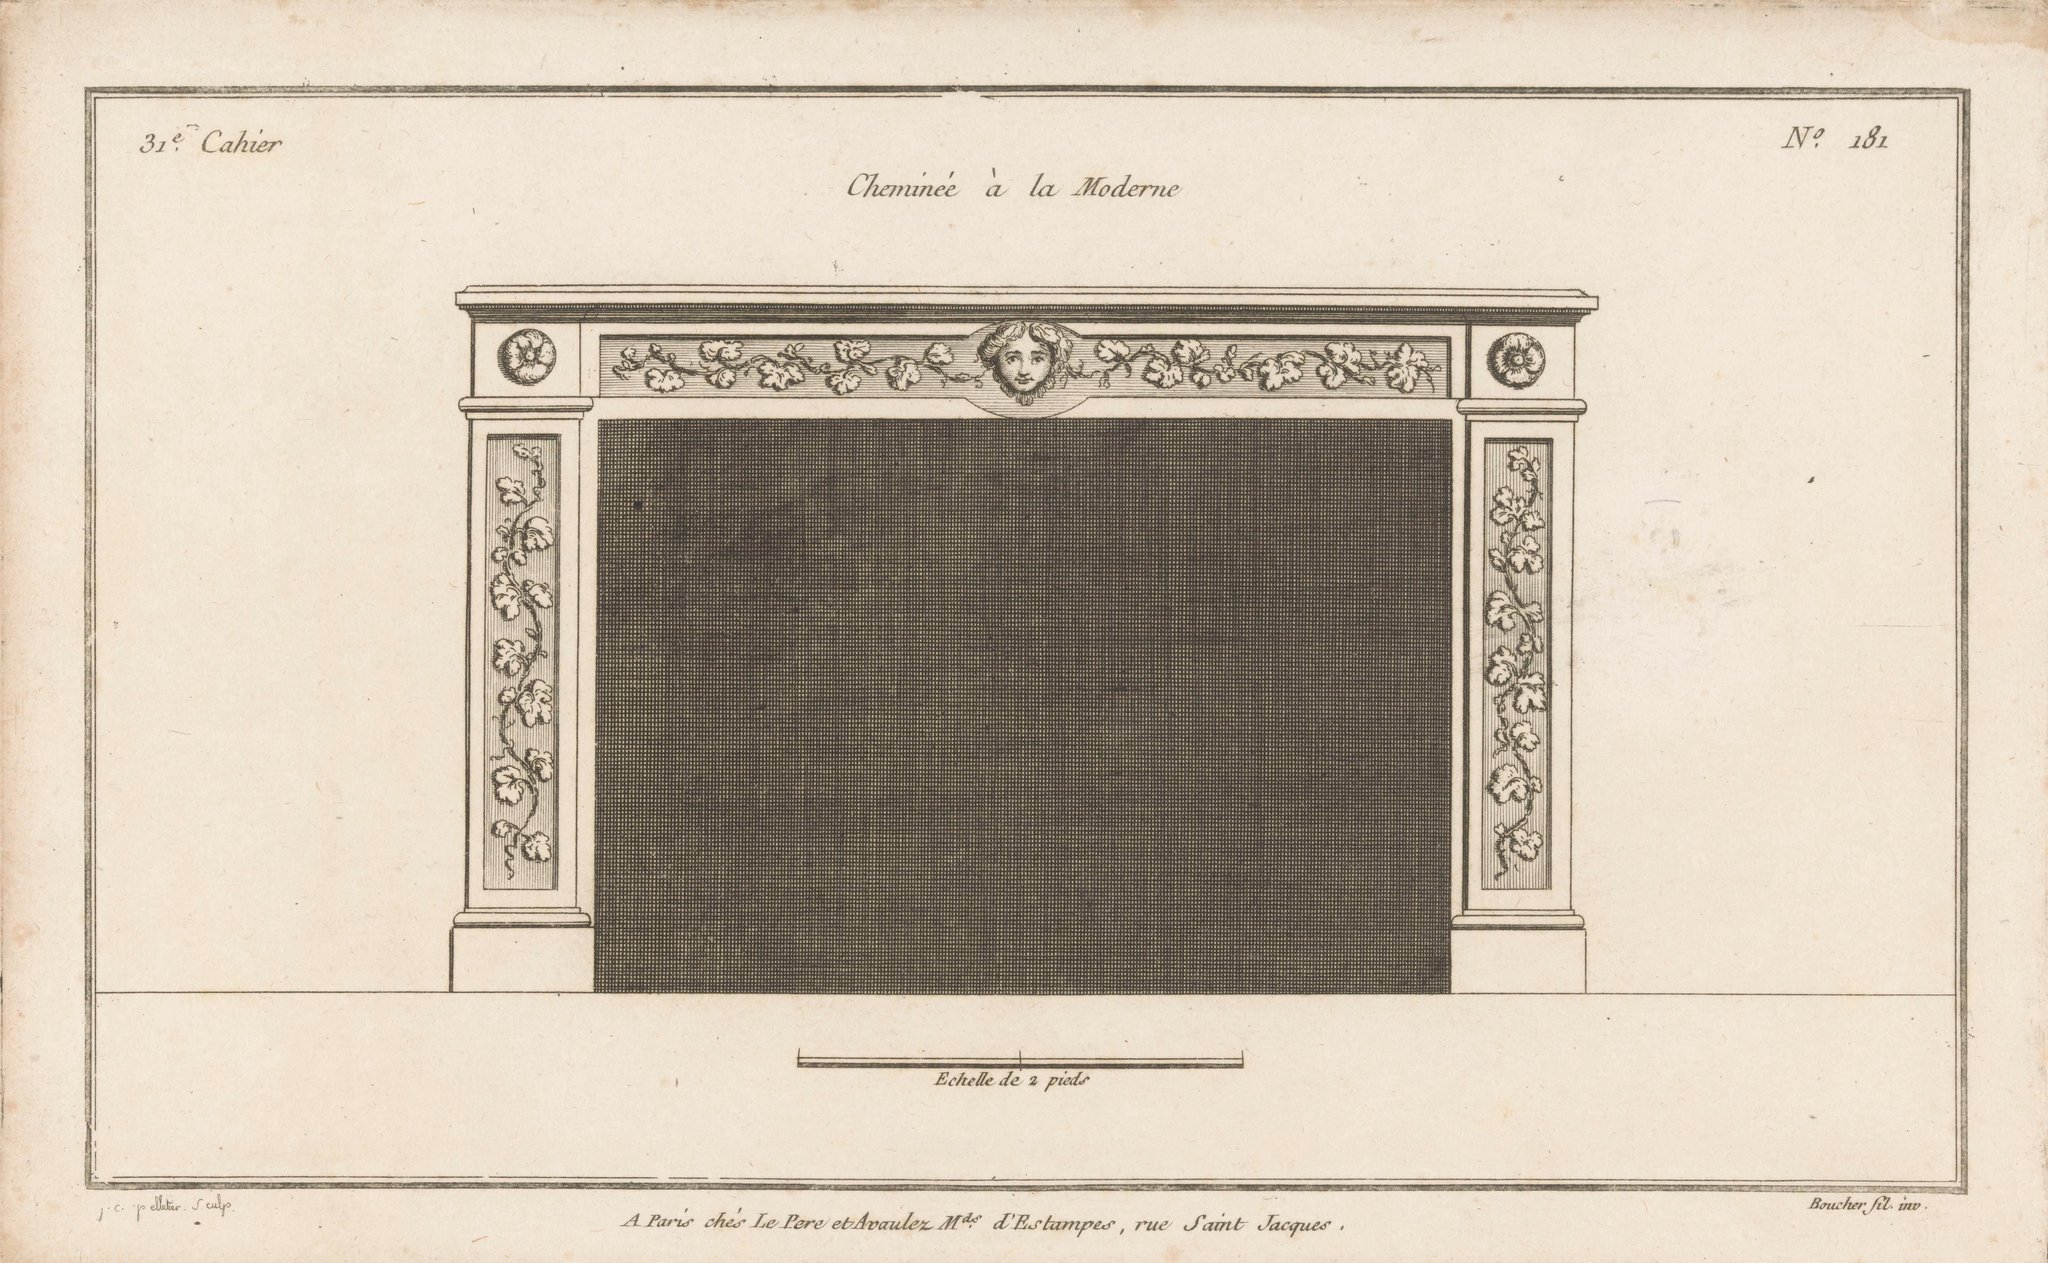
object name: print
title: 31e Cahier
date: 1772-1779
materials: paper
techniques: engraving, etching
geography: paris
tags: tendrils ~ ornament, open hearth, fire-place, mask, mascaron ~ ornament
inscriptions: collector's mark: Lugt 2760, collector's mark: Lugt 2228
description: Een open haard gedecoreerd met een masker, ranken en bloemmotieven. Prentnummer 181.